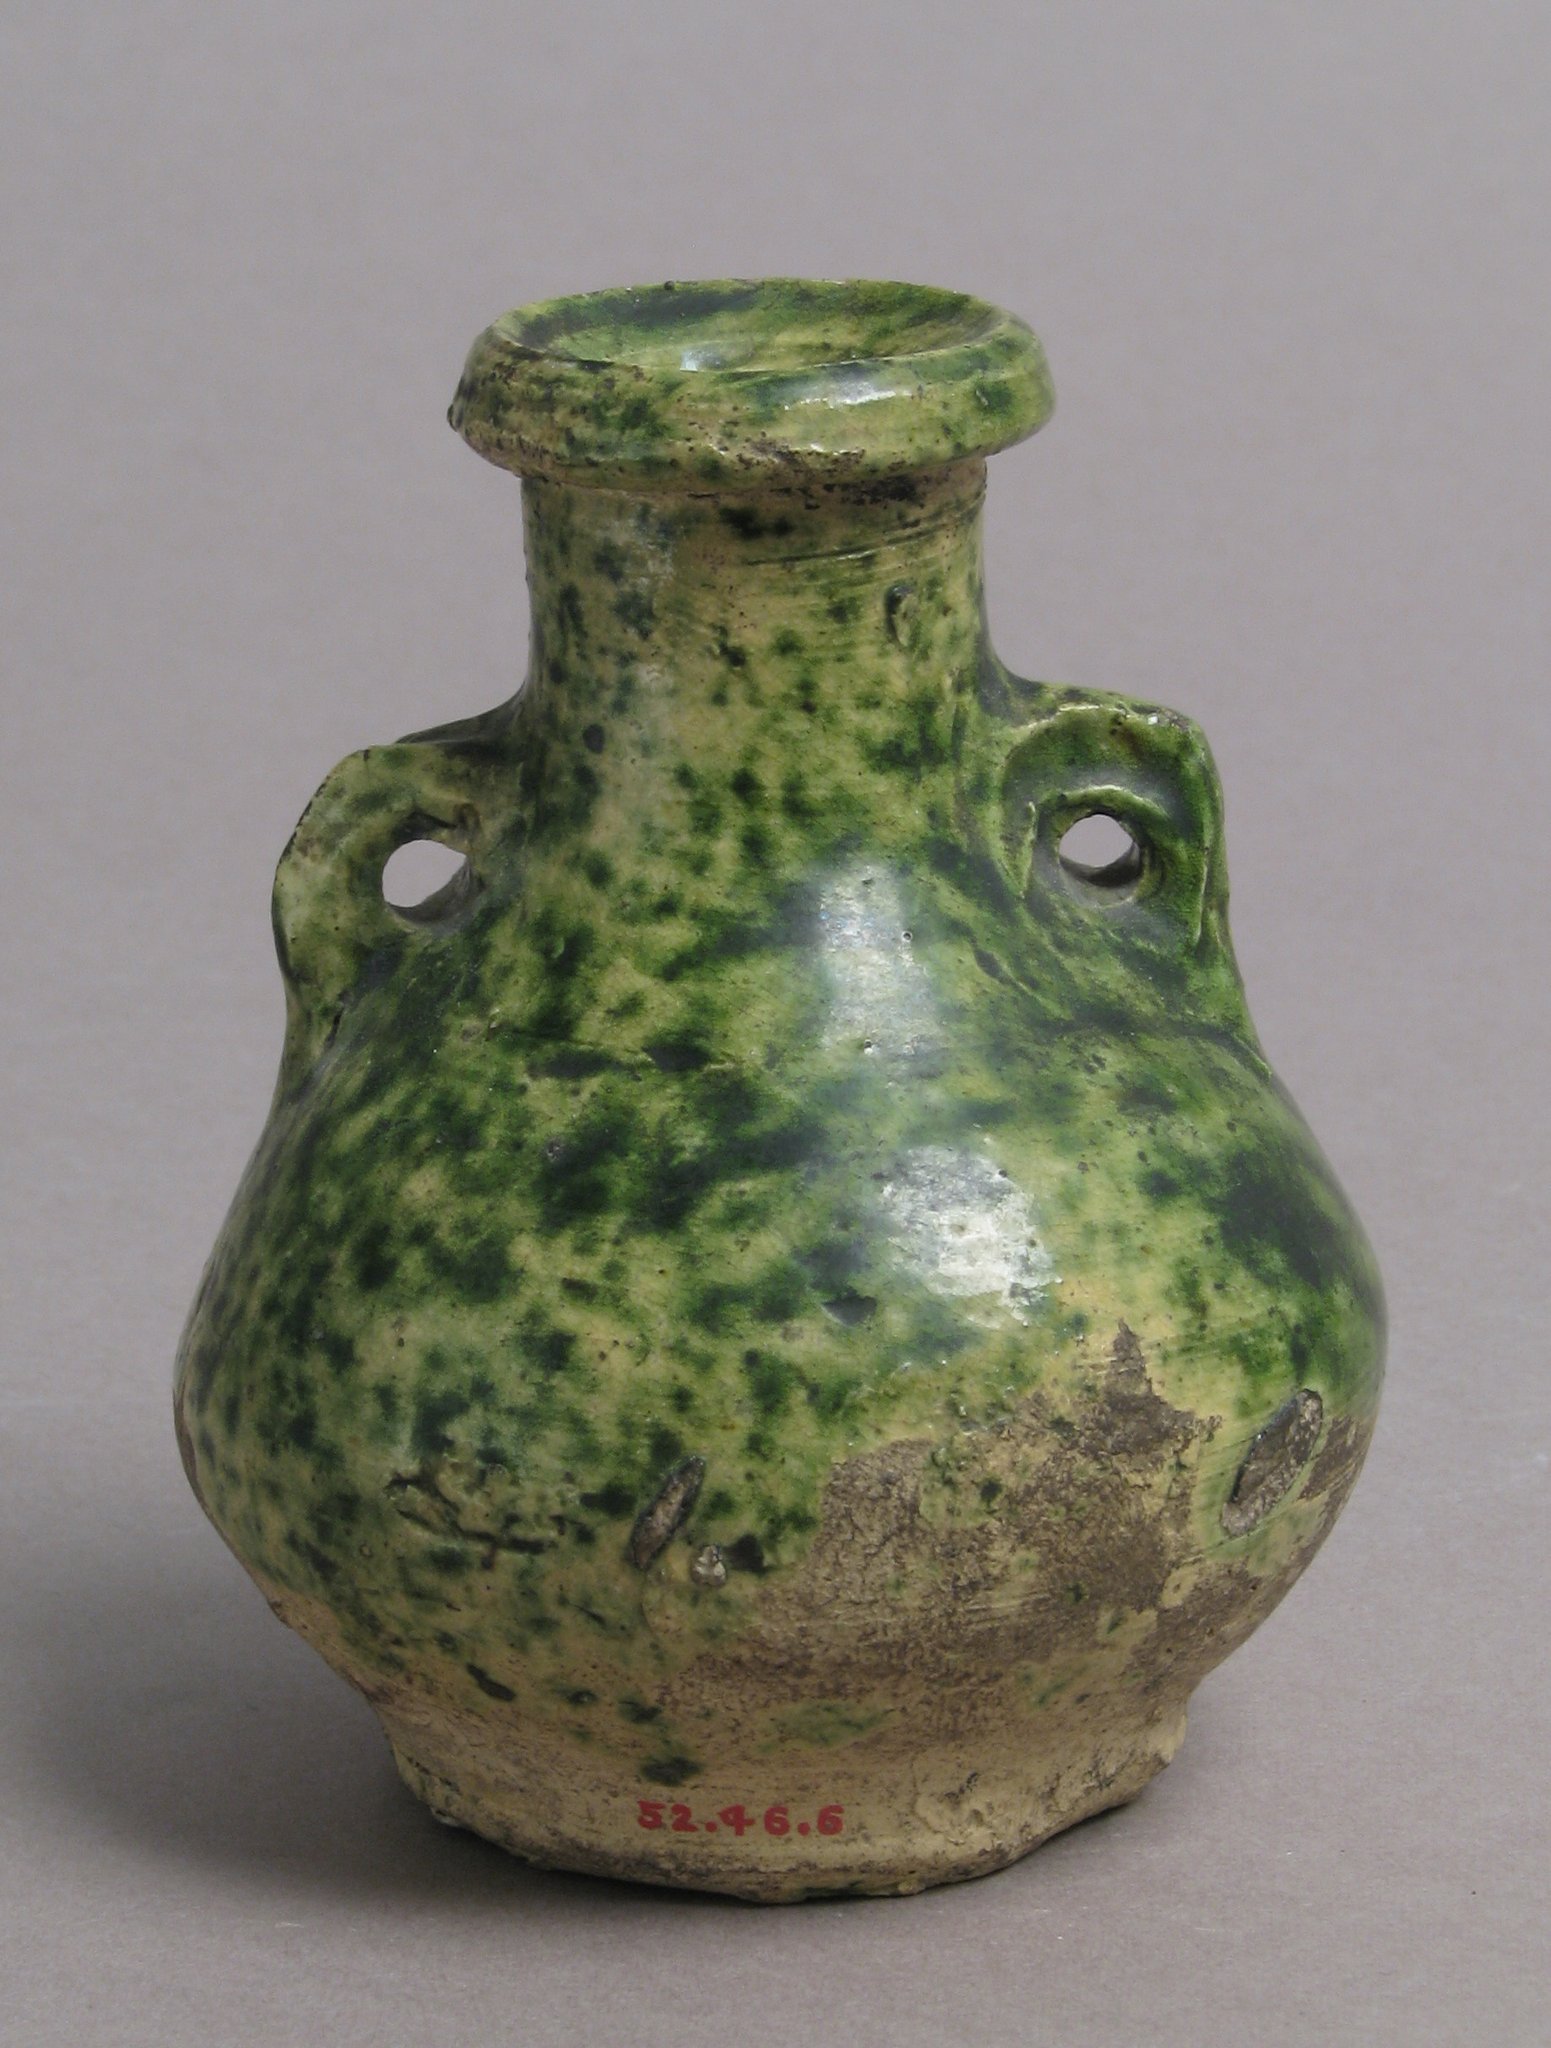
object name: jug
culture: british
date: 1401-1600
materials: earthenware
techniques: glazing